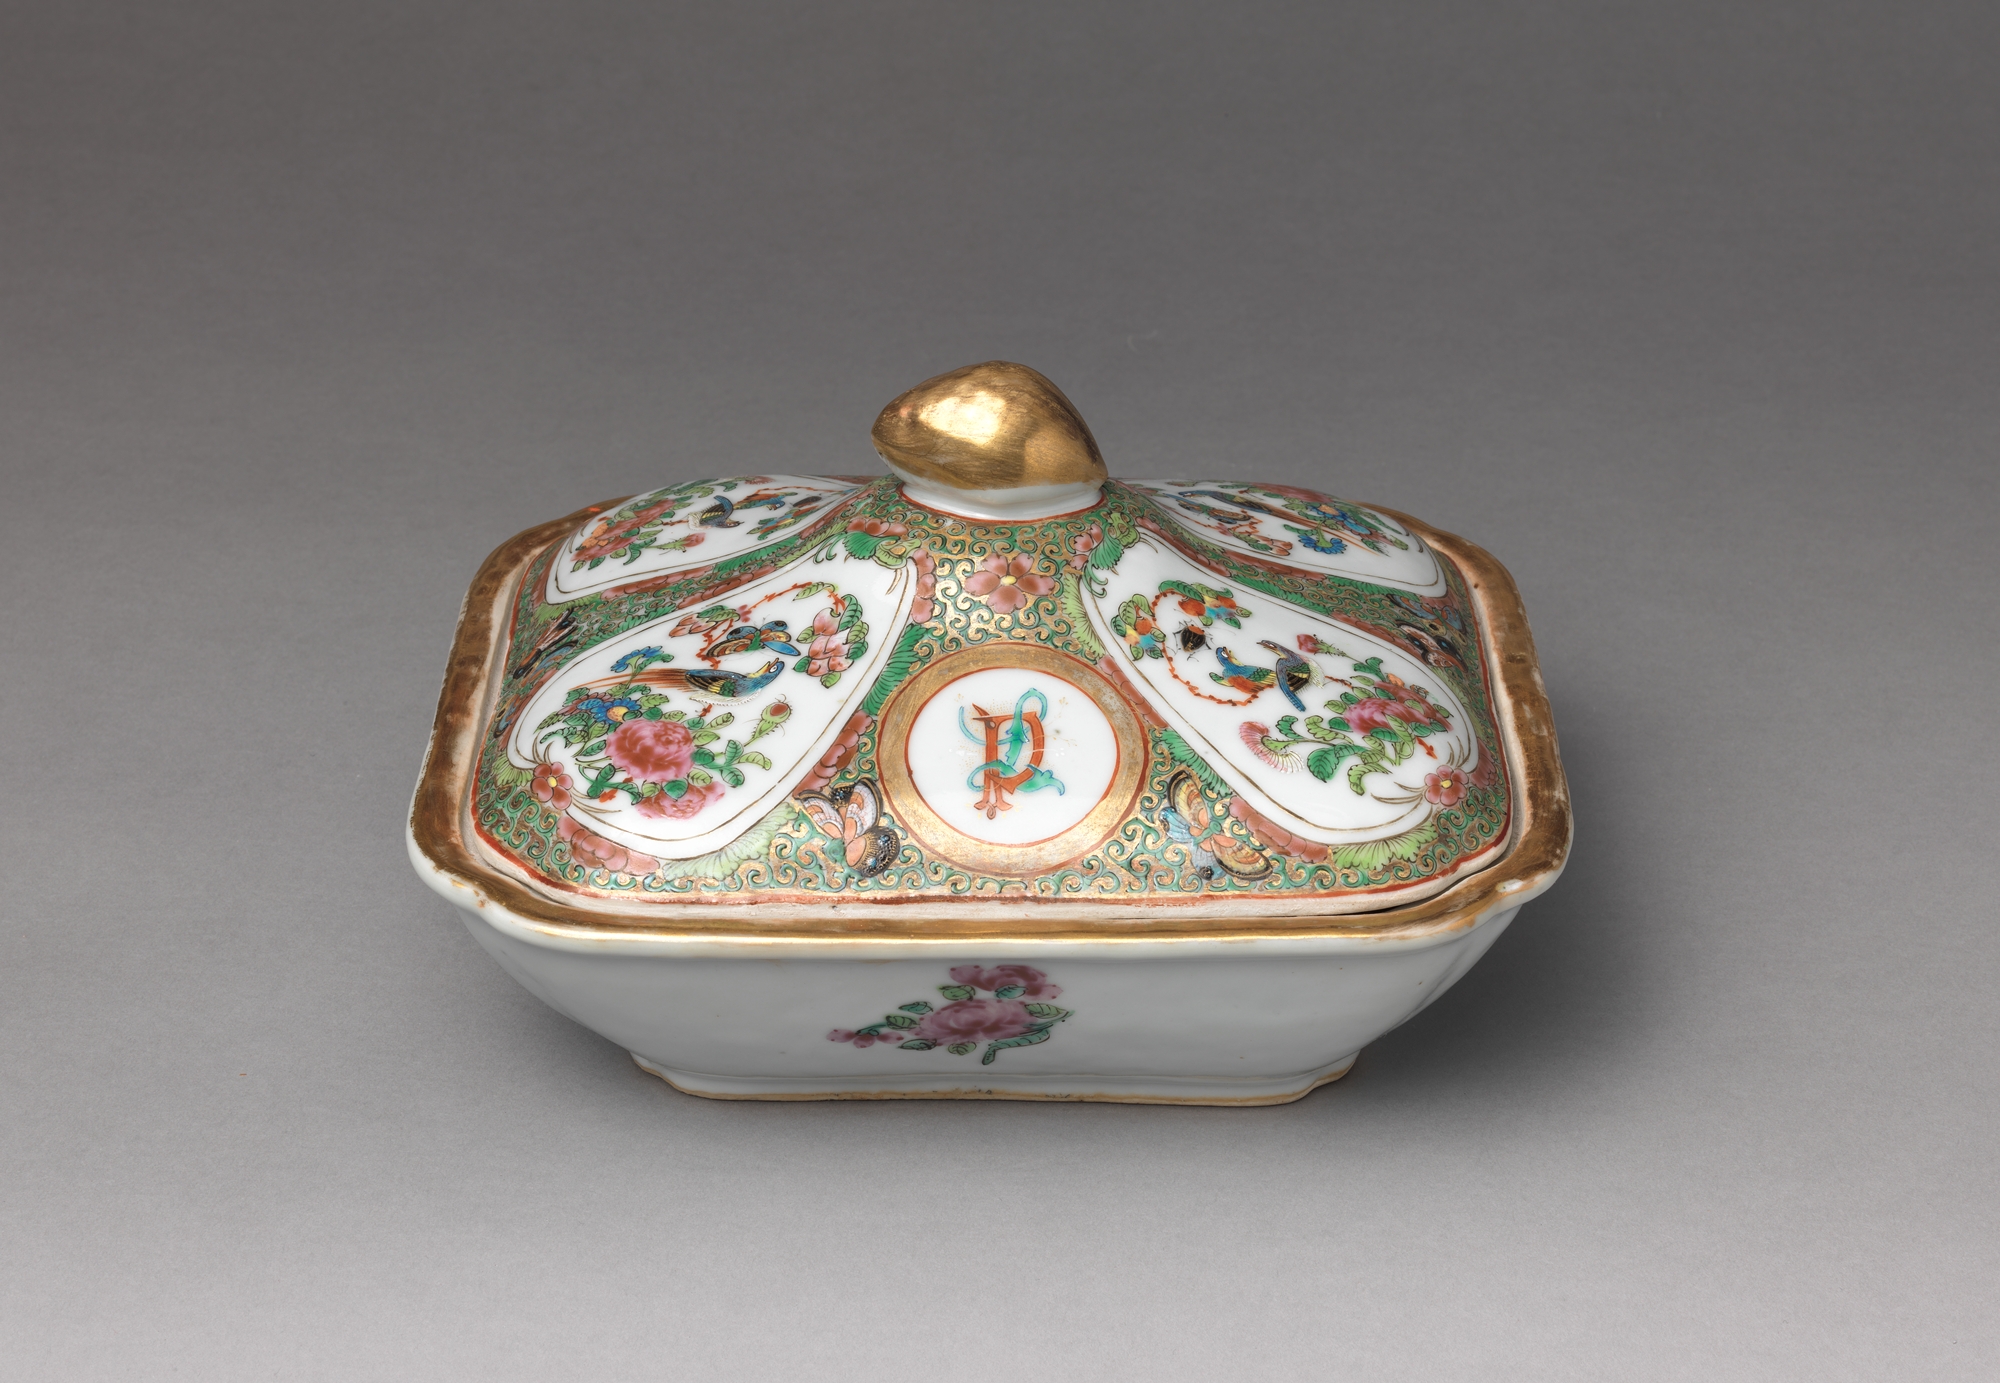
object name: serving dish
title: Covered Serving Dish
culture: chinese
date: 1860-1866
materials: porcelain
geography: china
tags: birds,flowers